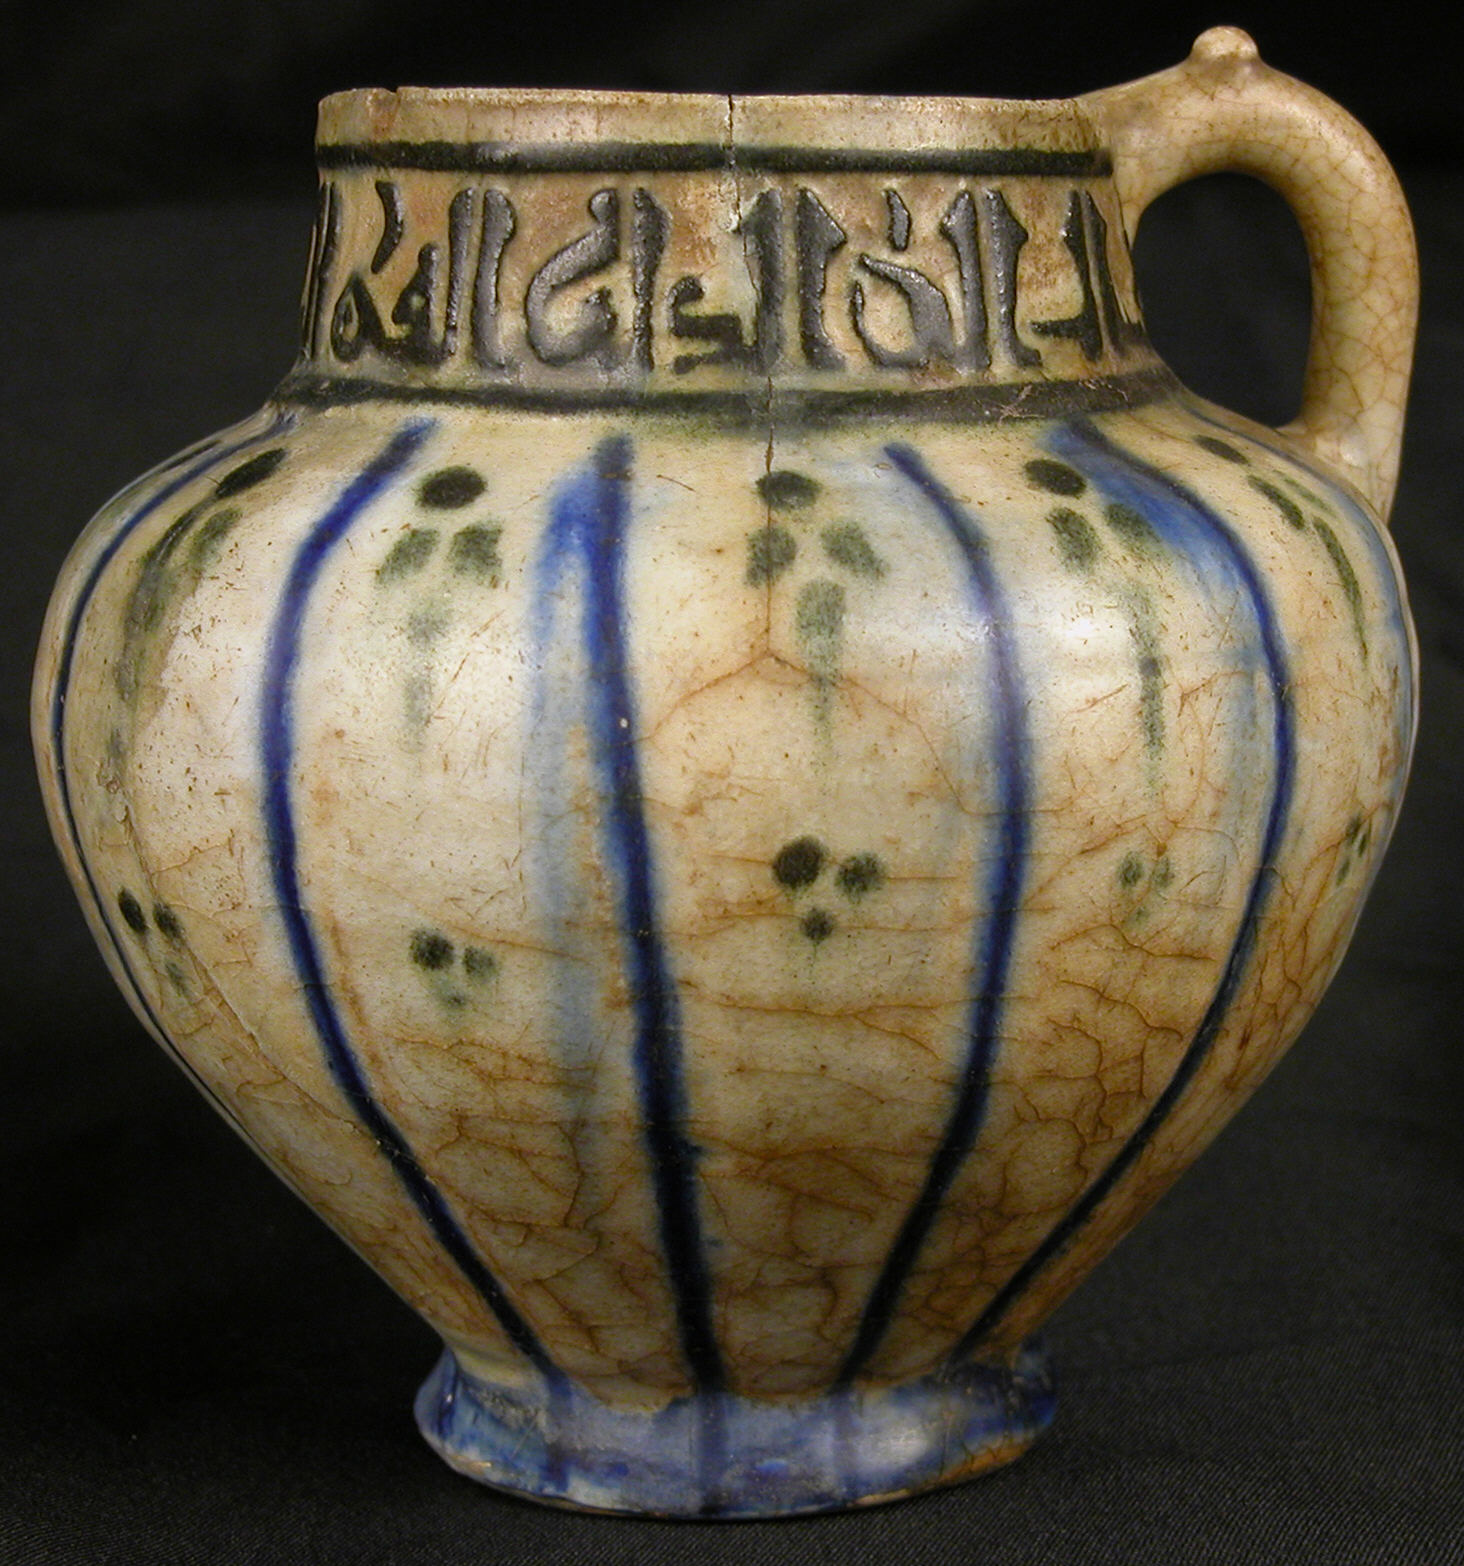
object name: ewer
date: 1167-1233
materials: glaze, stoneware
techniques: carving, painting, underglaze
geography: iran